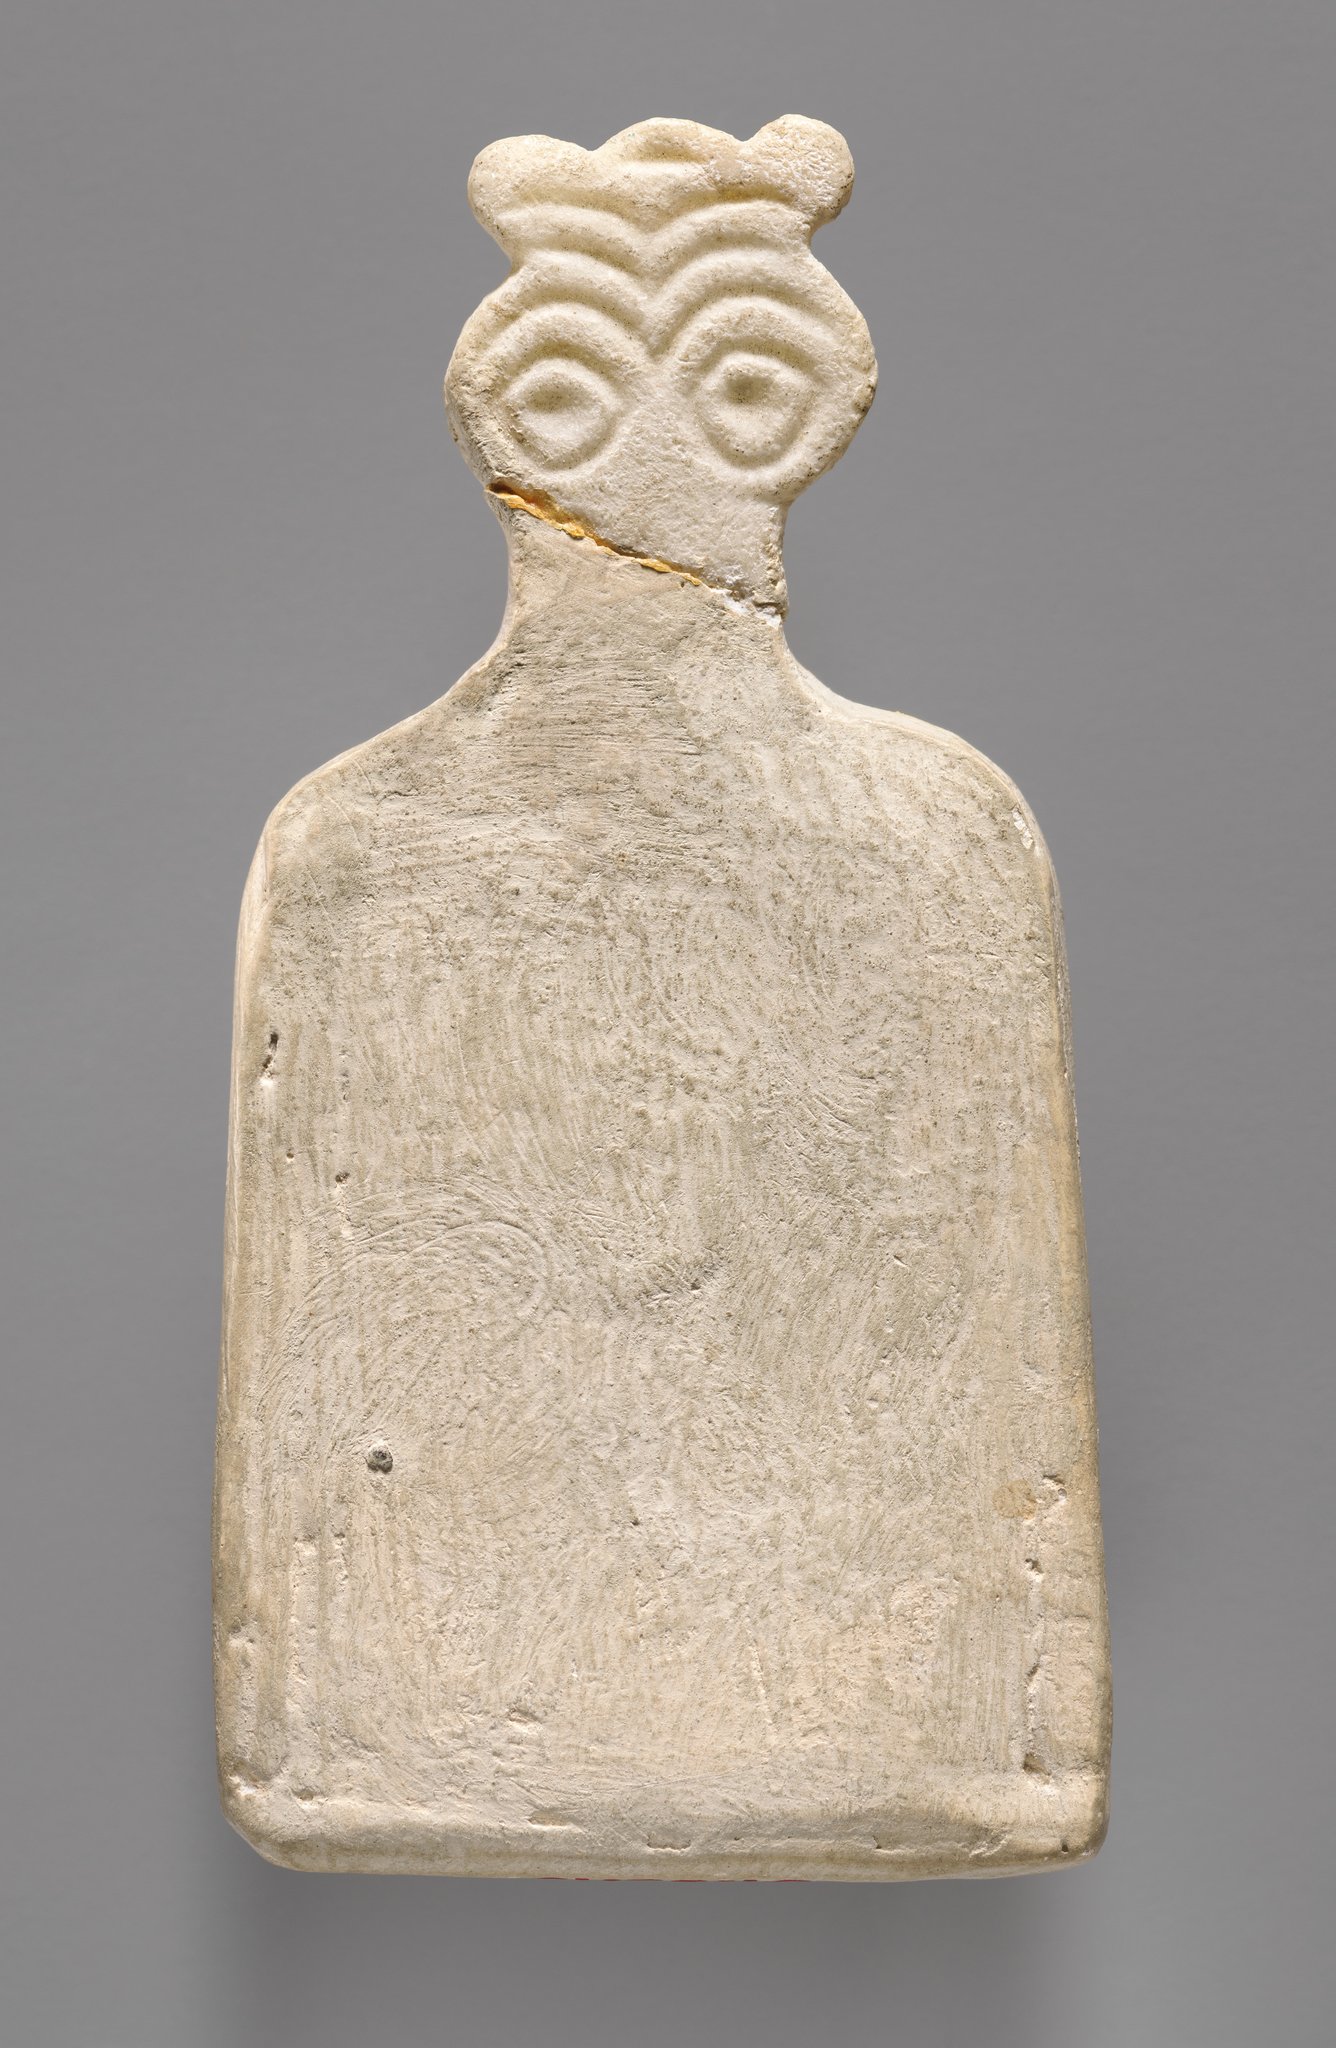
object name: sculpture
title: Eye idol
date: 3700-3500 BCE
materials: alabaster, gypsum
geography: syria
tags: eyes